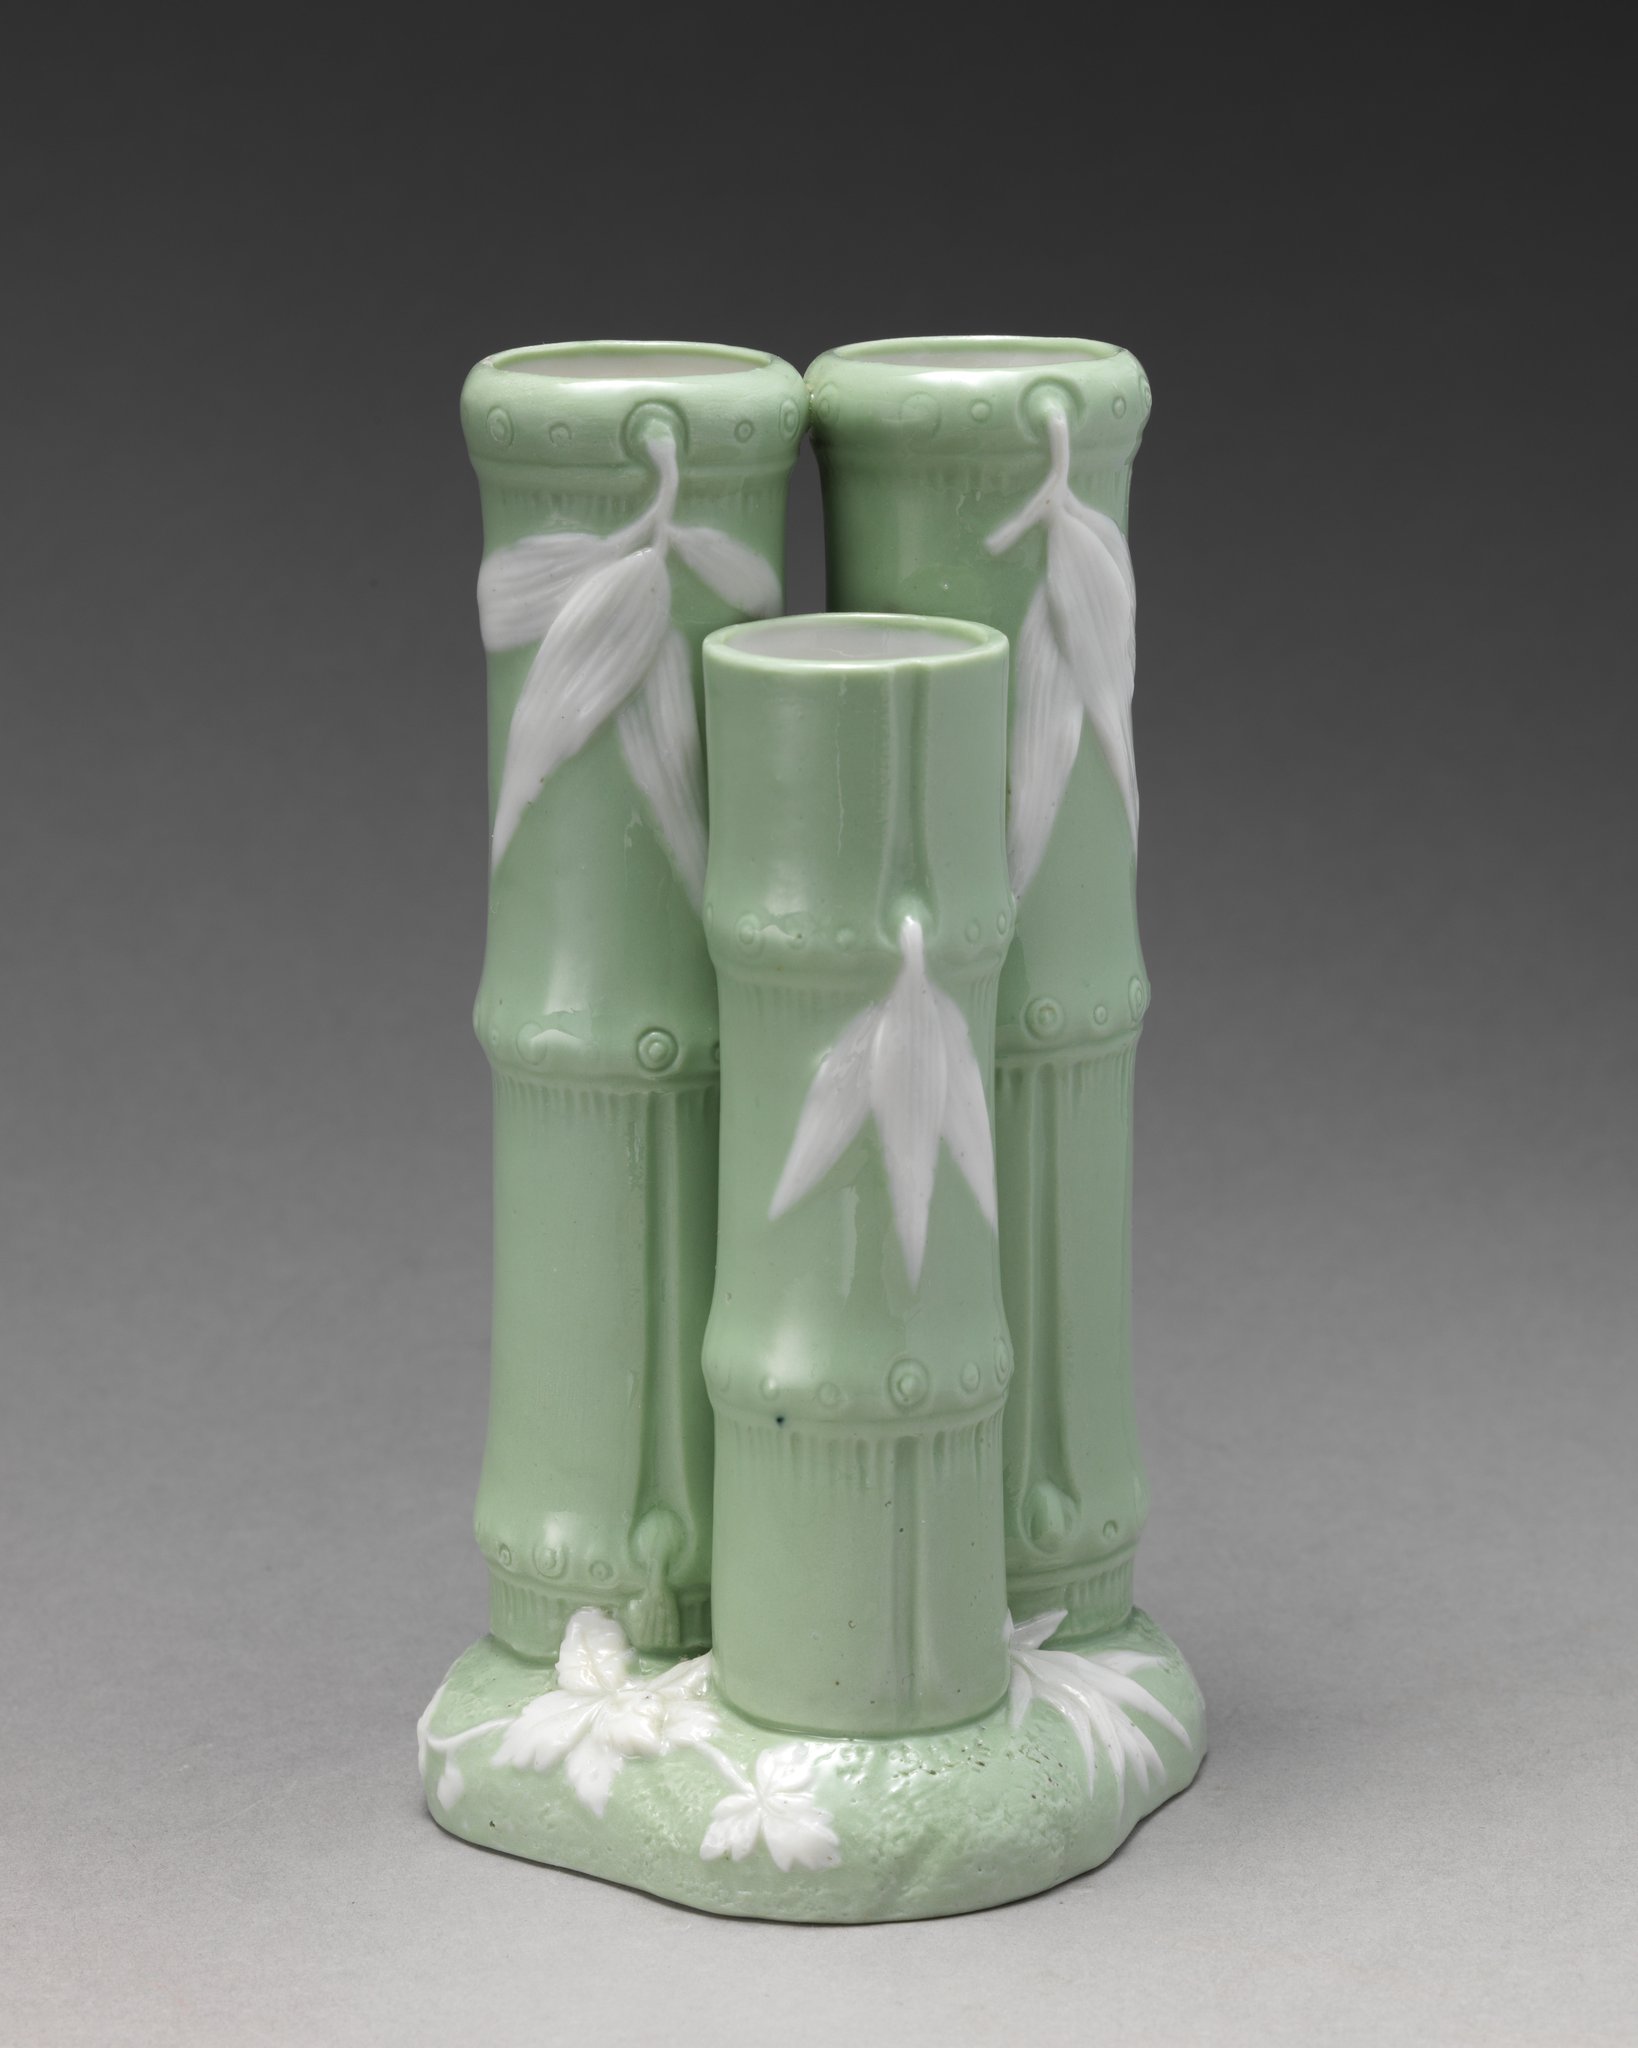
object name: vase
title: Triple vase in form of bamboo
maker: minton(s)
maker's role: maker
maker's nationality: british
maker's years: 1793-2001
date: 1870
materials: bone china